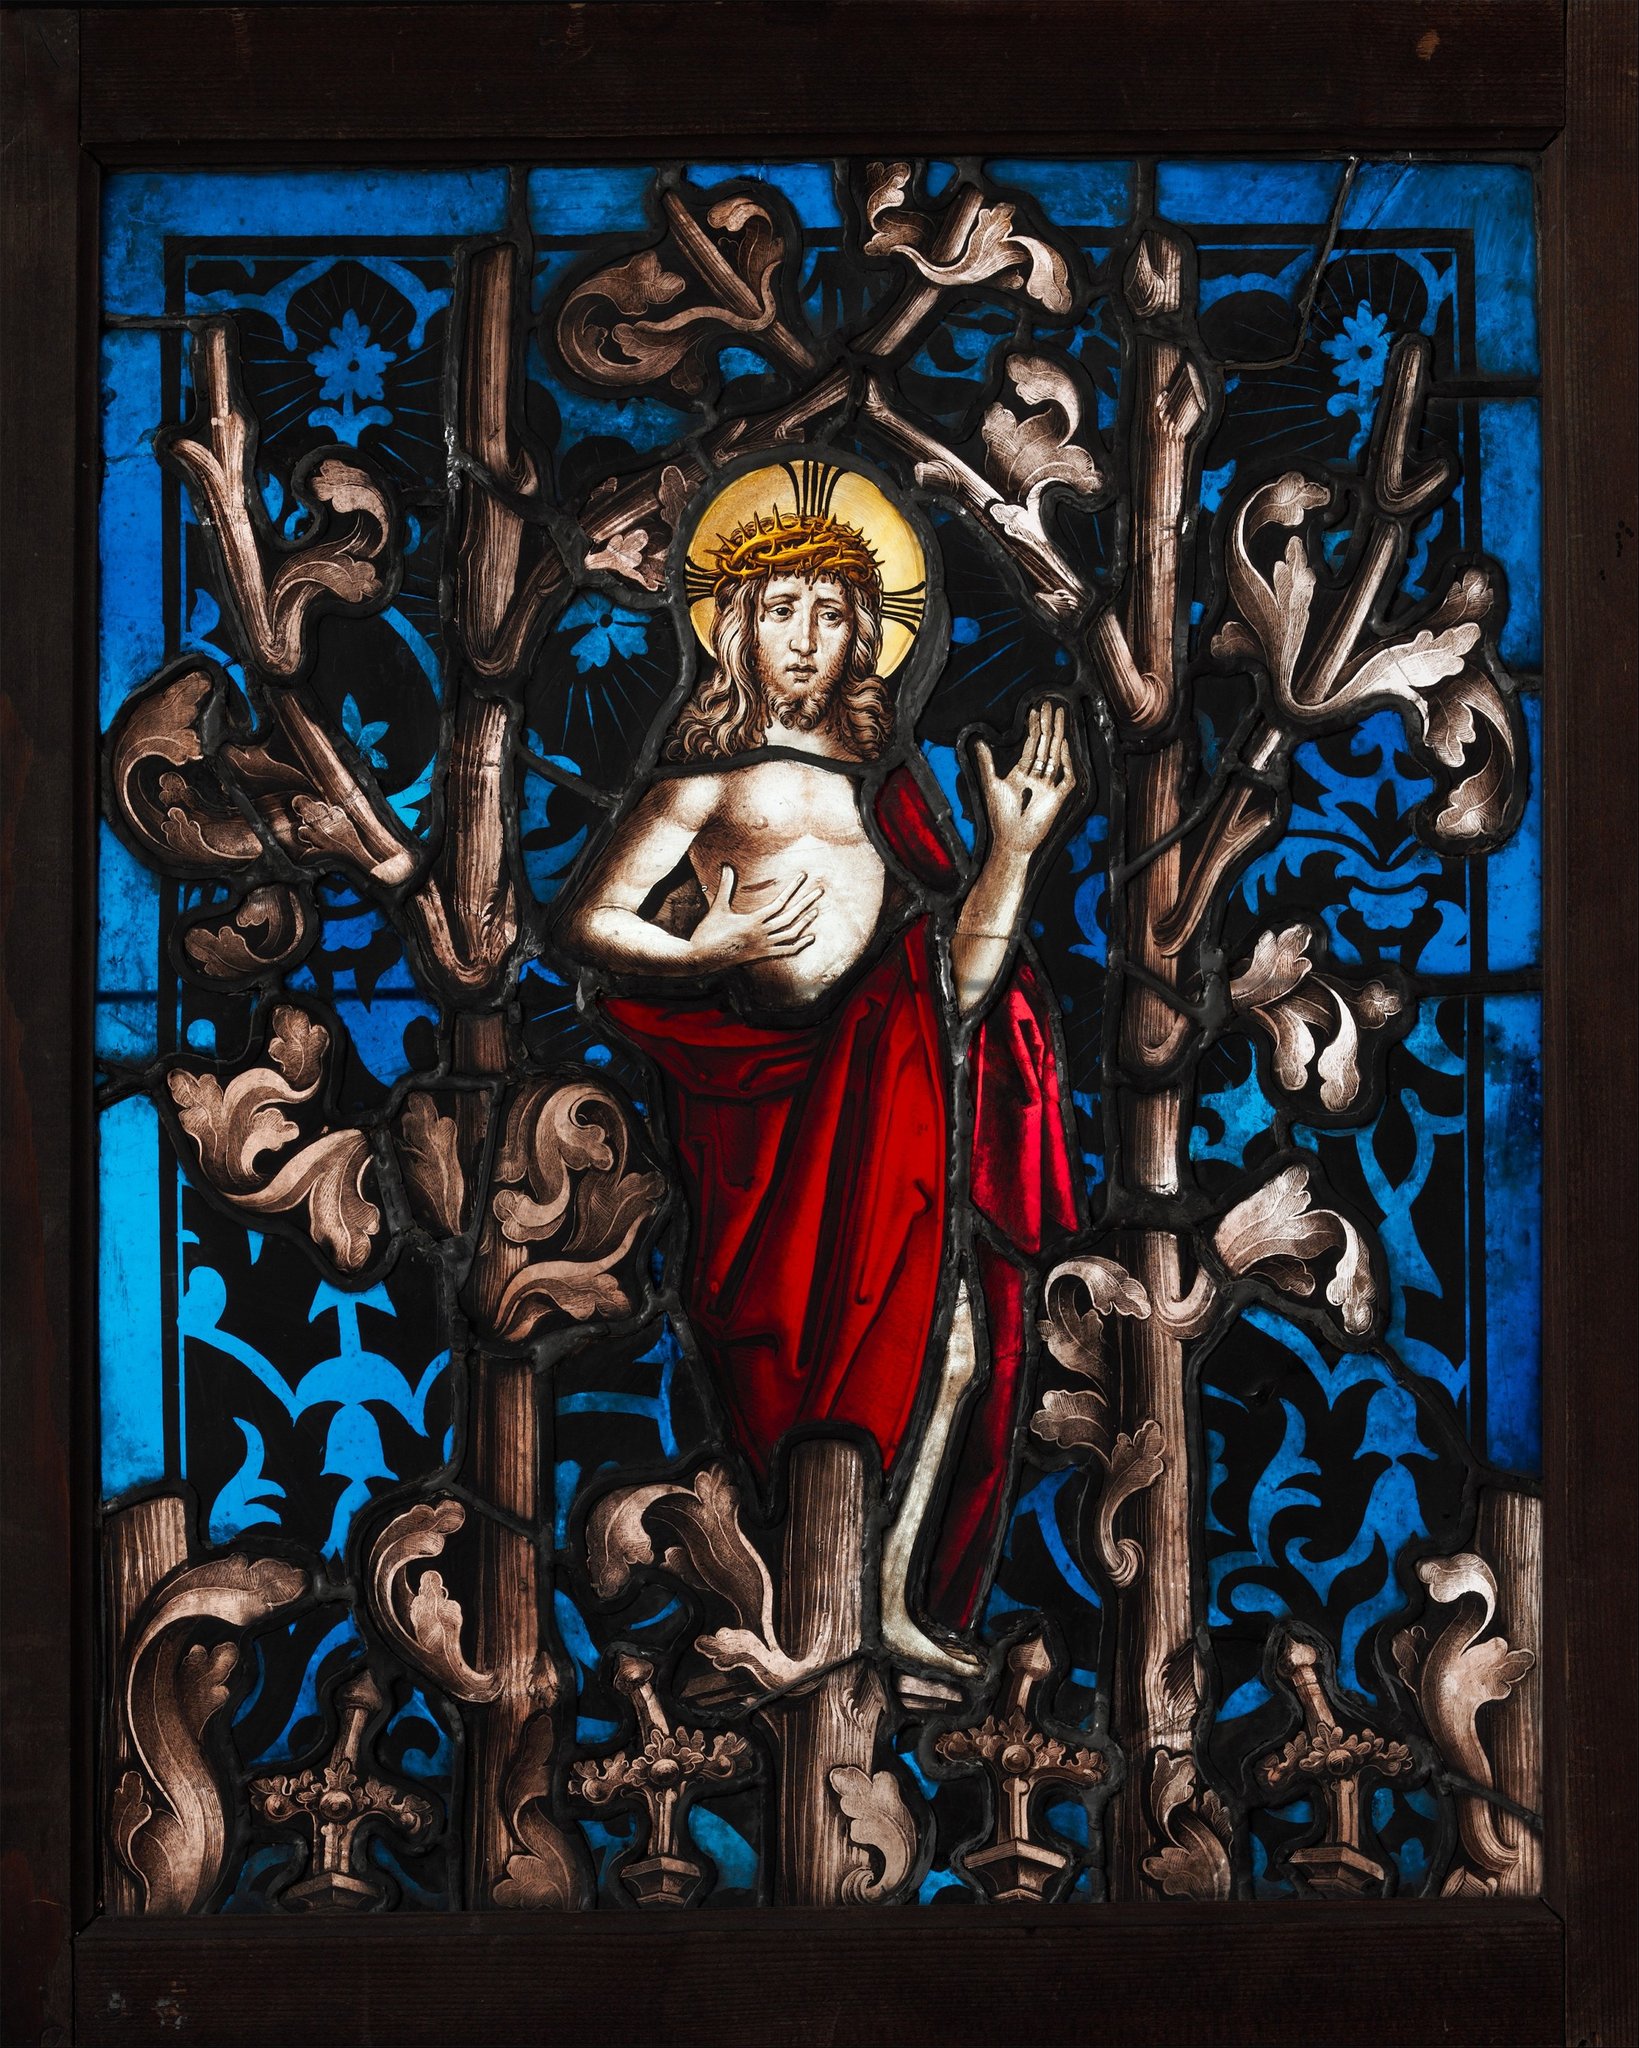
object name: stained glass panel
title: Man of Sorrows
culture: german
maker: lautenbach master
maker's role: artist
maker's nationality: german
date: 1480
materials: glass, metal, paint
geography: france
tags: christ